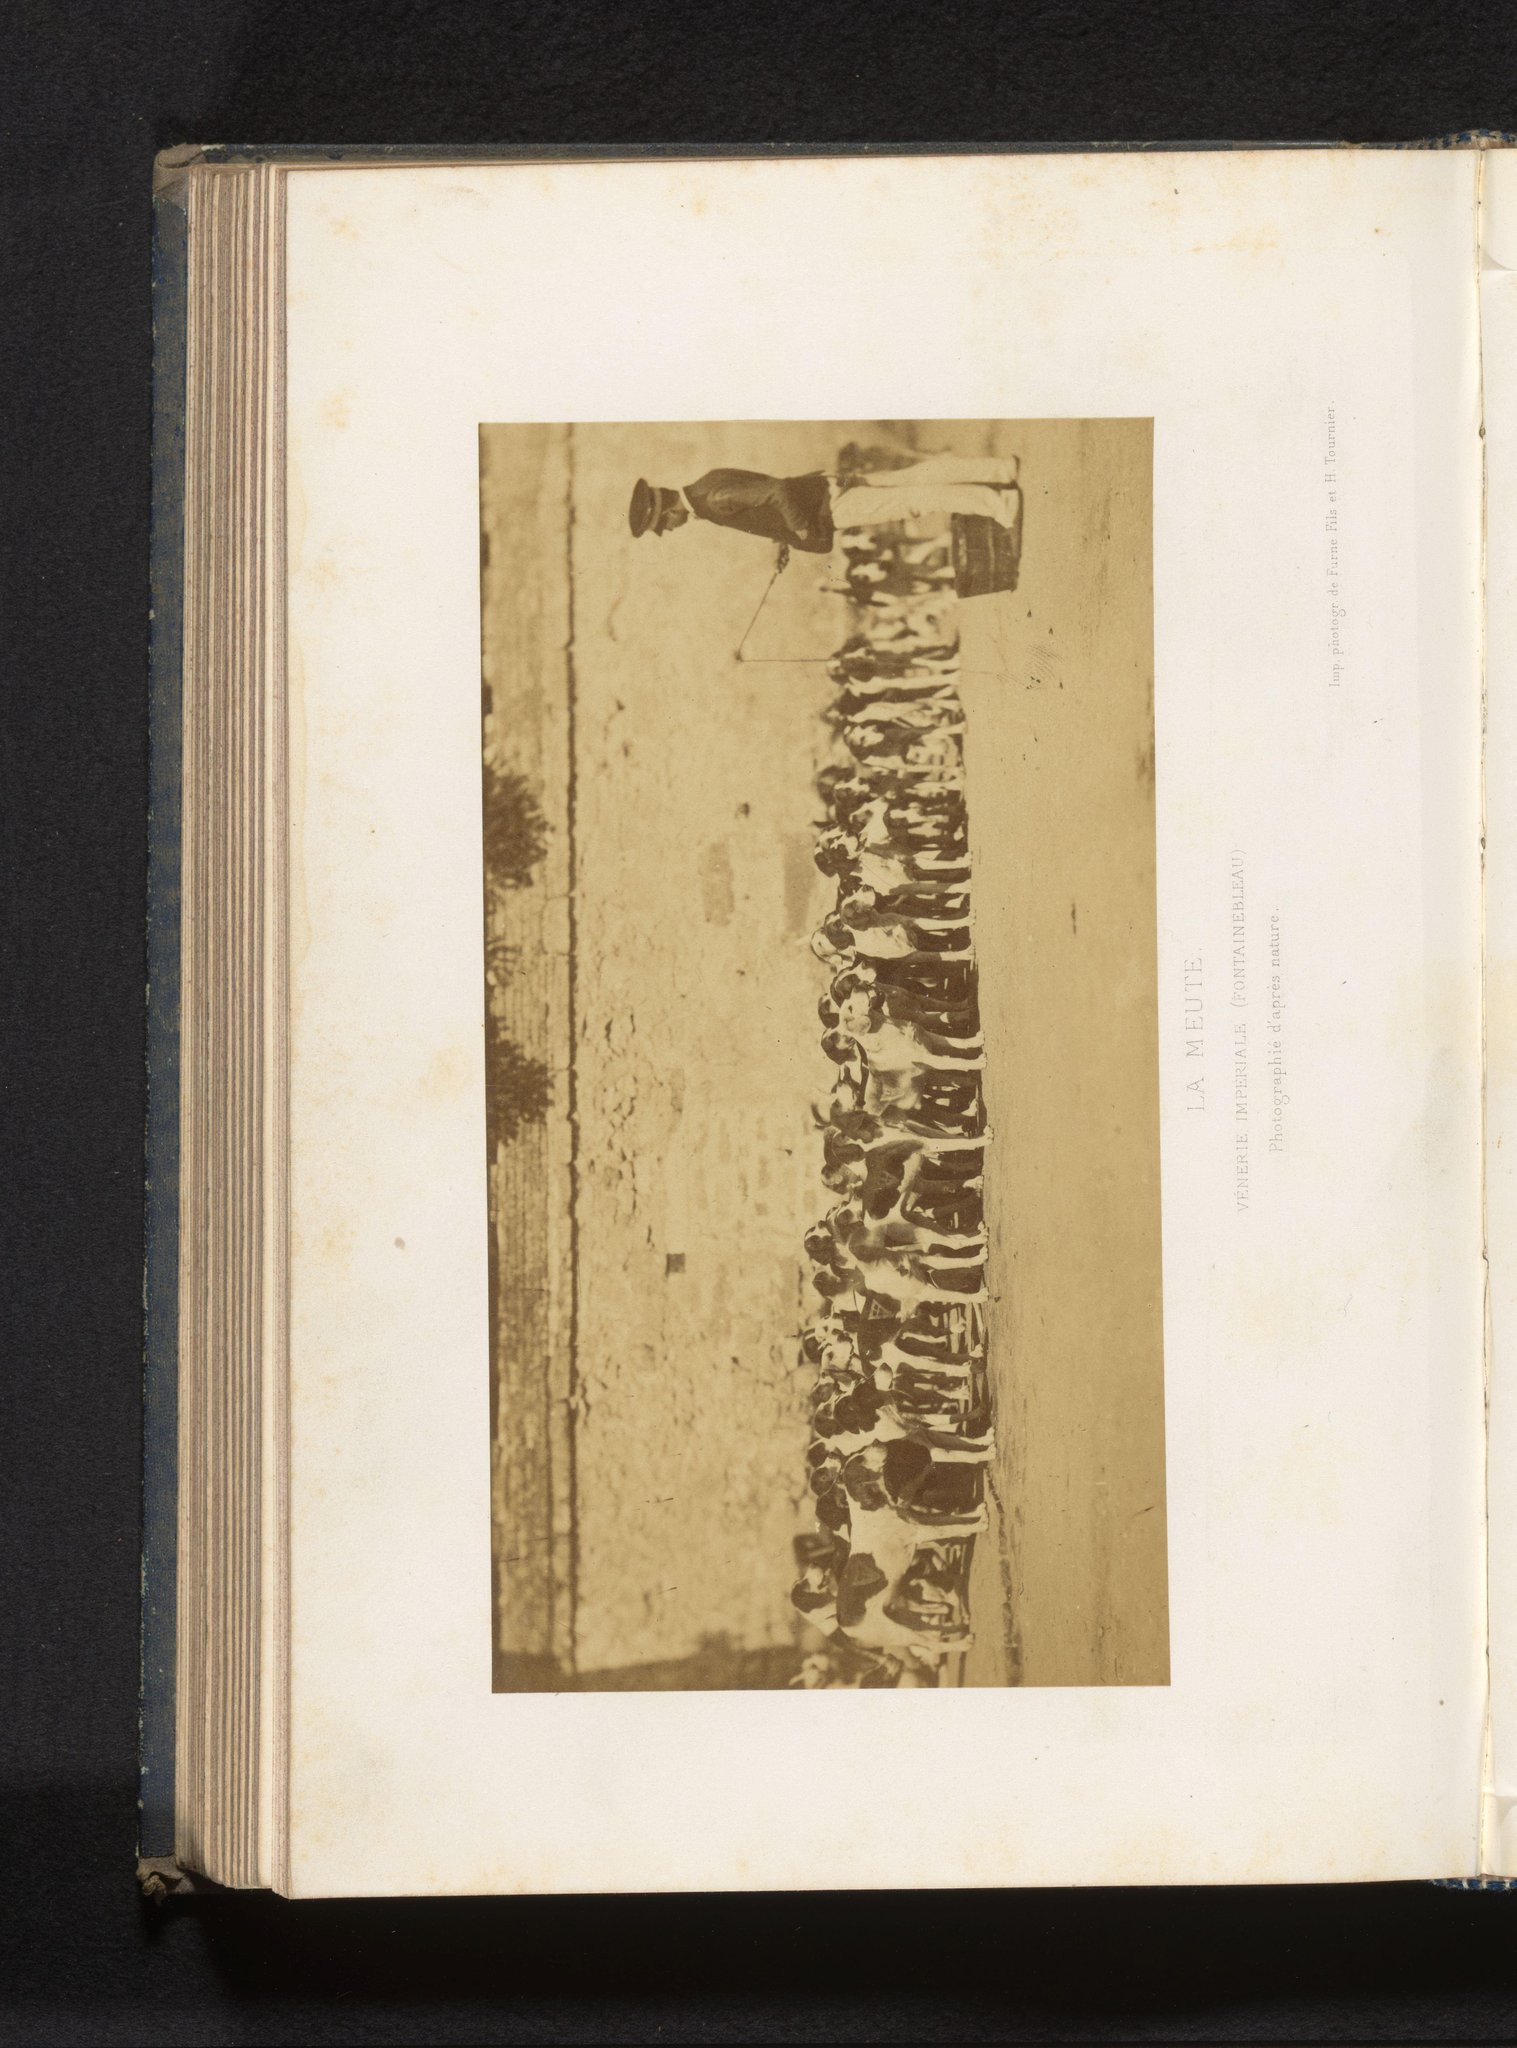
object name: photograph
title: Onbekende man met een roedel honden bij de keizerlijke kennel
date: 1856-1861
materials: photographic support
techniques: albumen print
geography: fontainebleau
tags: adult man, historical persons, dog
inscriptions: inscription: ‘Photographie d'après nature’